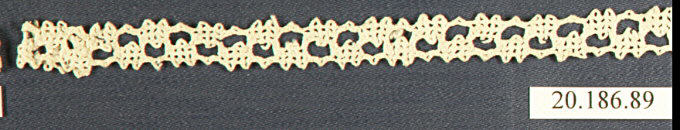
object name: insertion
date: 1501-1600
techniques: lace